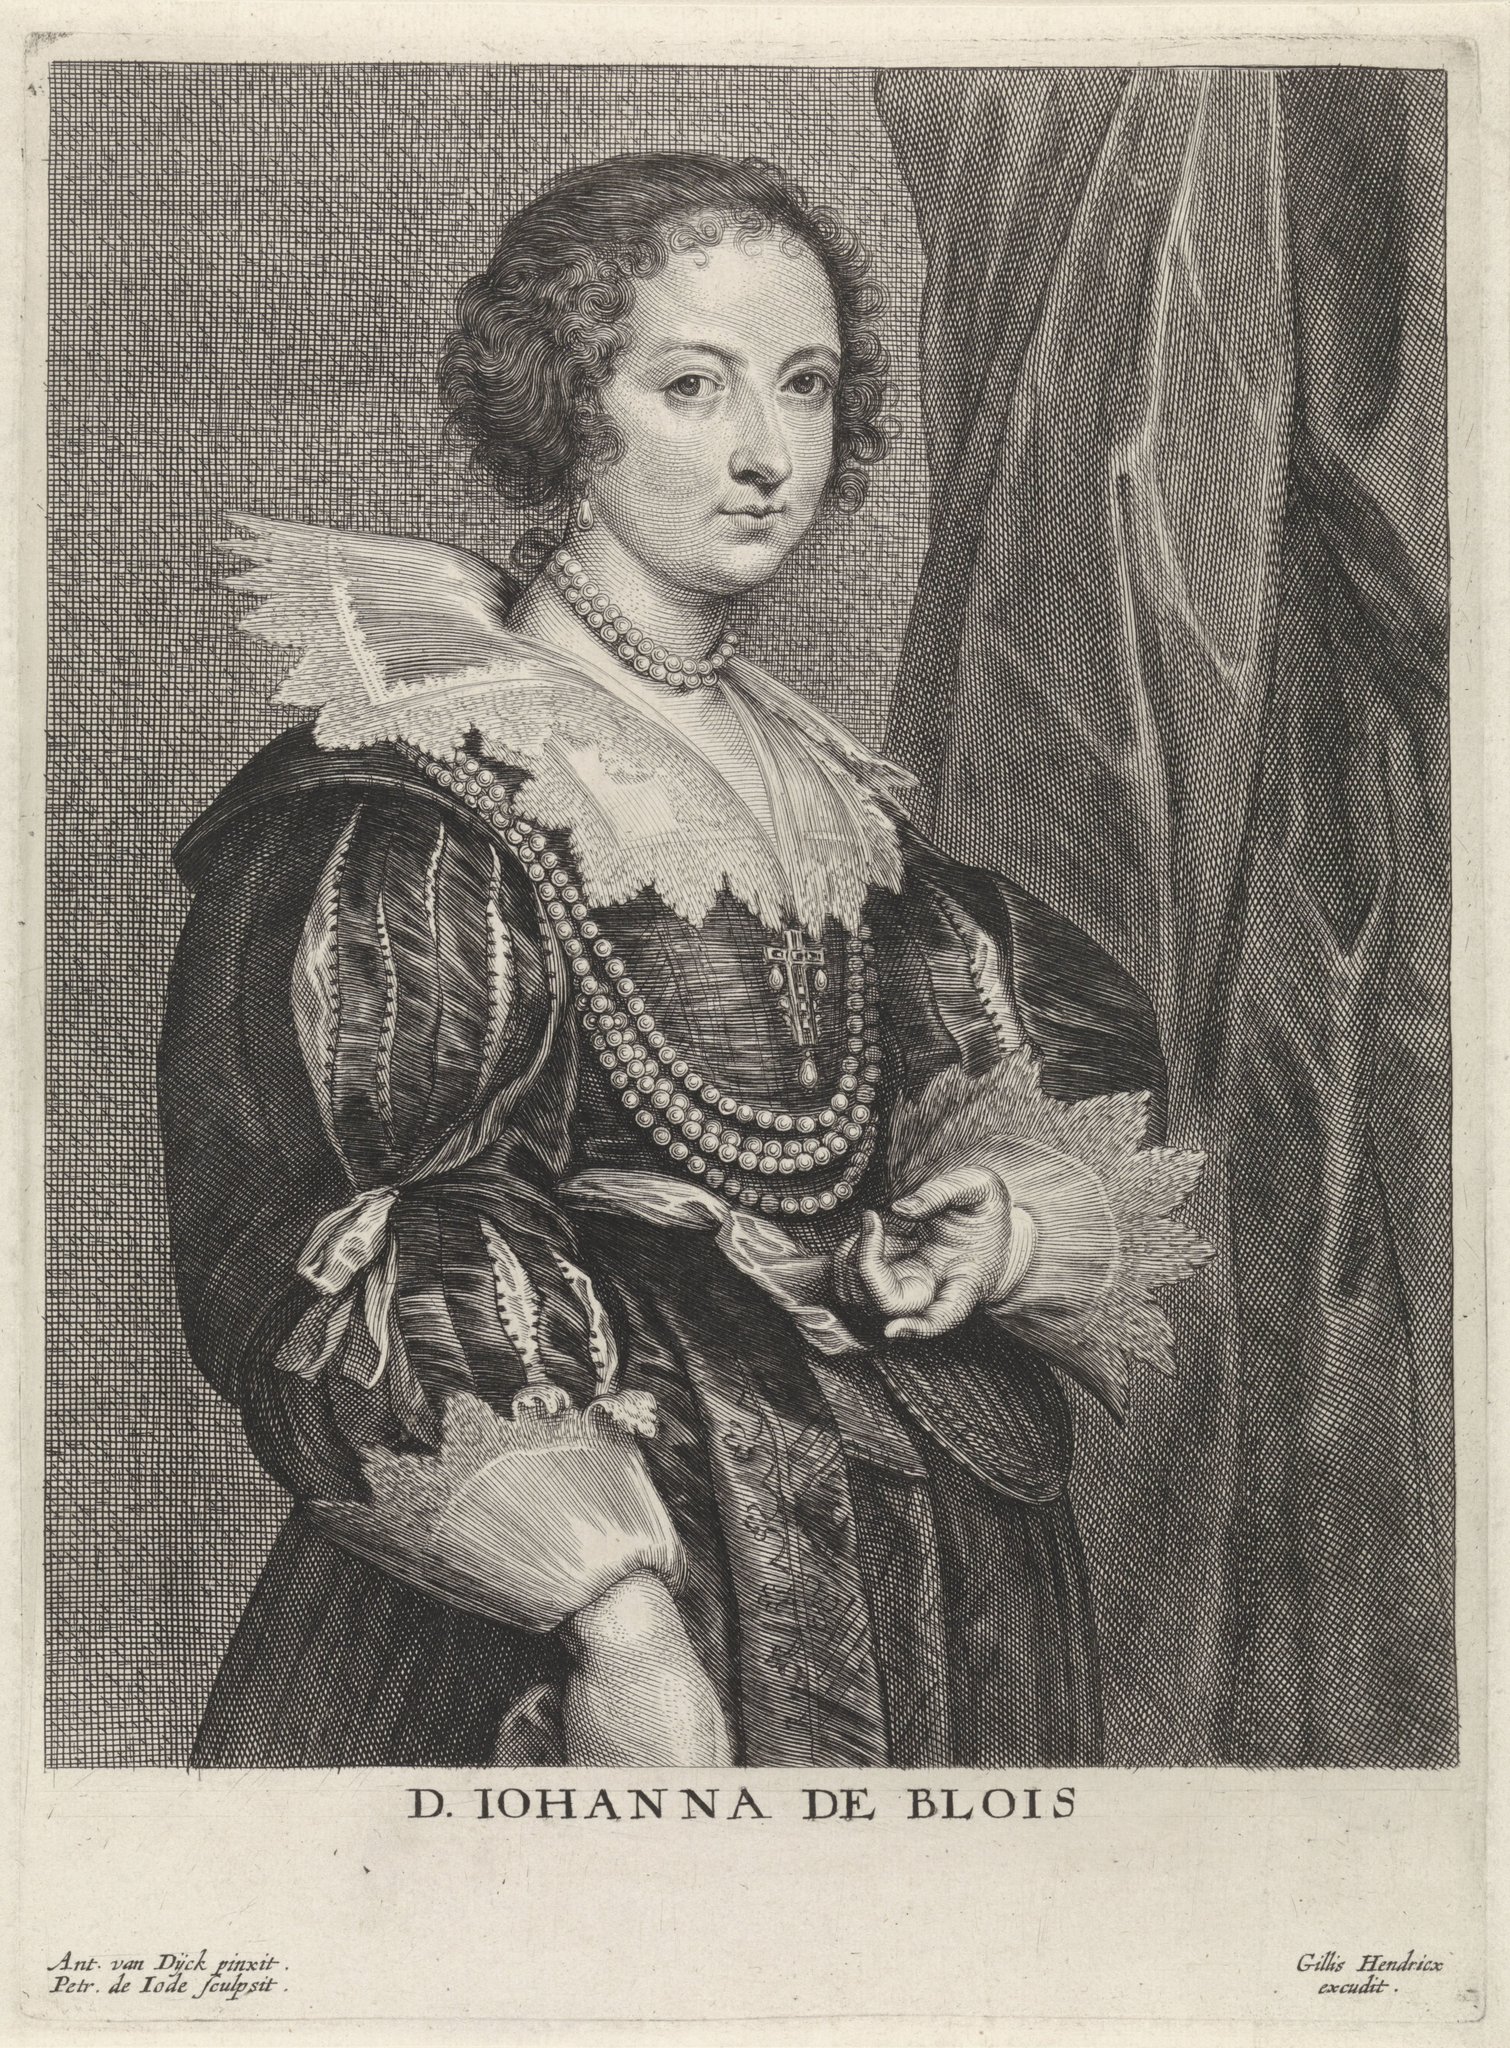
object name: print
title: Portret van Johanna van Blois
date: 1628-1670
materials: paper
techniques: engraving, etching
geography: antwerp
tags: johanna van blois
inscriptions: collector's mark: Lugt 240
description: Portret van Johanna van Blois, ten halven lijve. In de marge de naam van de geportretteerde.